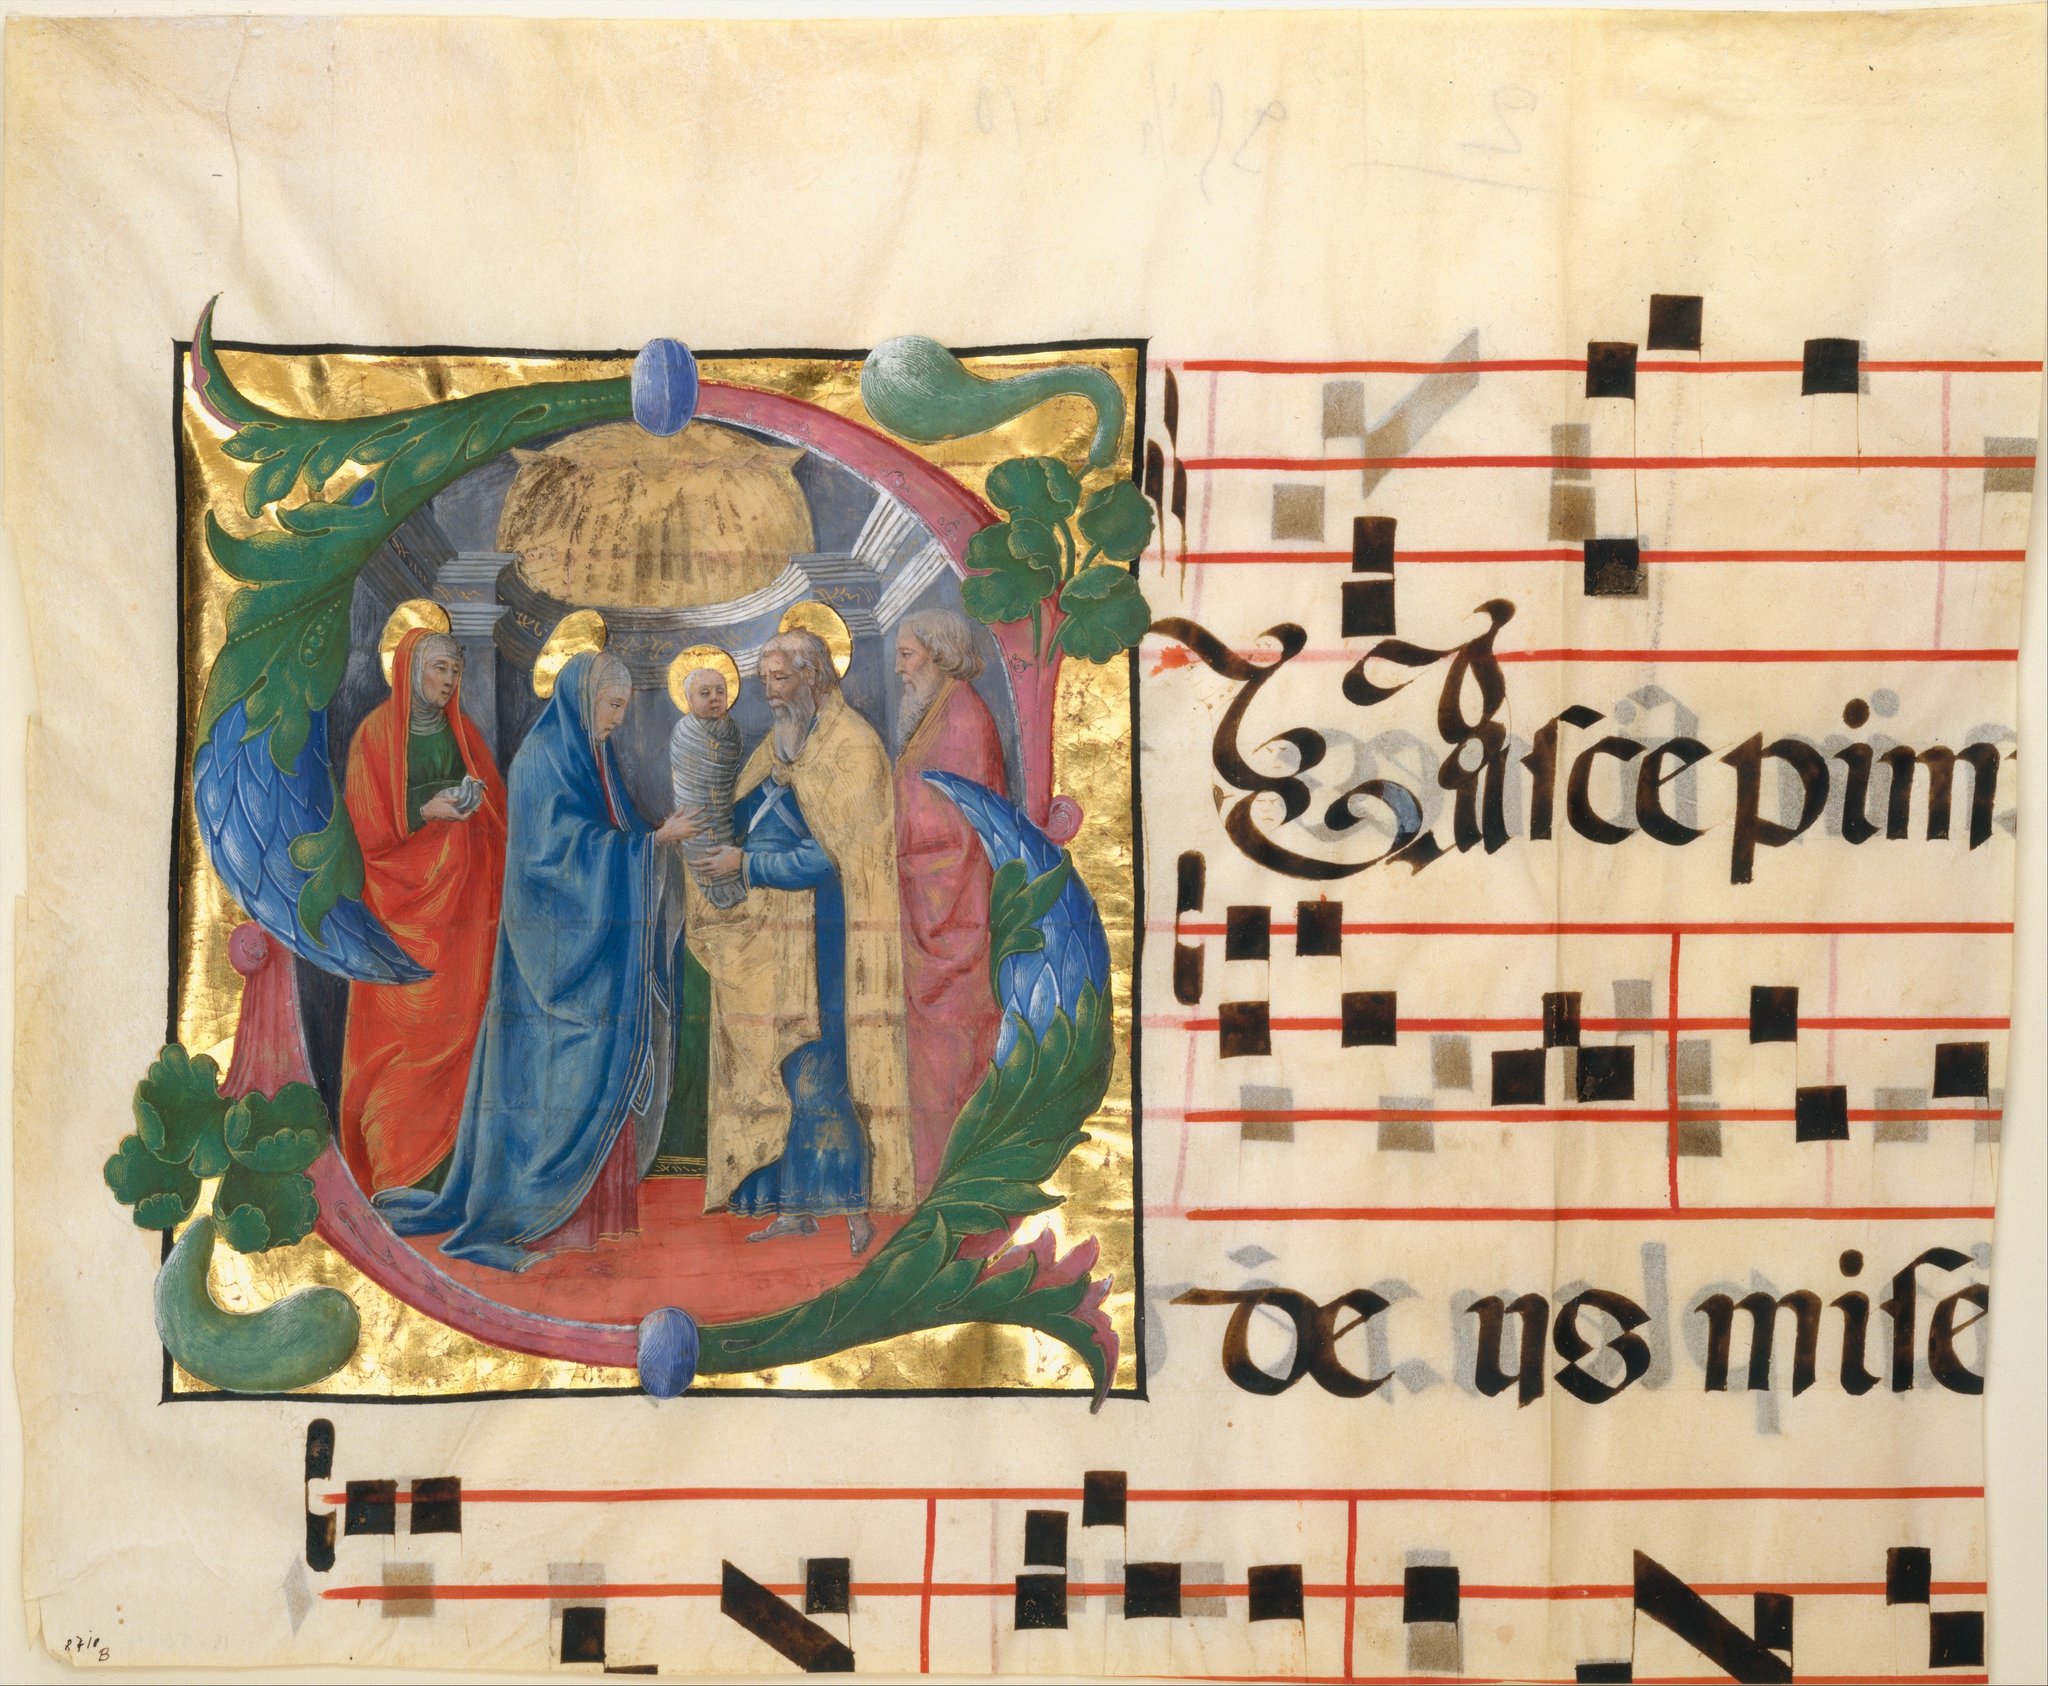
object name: gradual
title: Manuscript Illumination with the Presentation in the Temple in an Initial S, from a Gradual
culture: italian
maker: cosmè tura (cosimo di domenico di bonaventura)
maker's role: artist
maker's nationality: italian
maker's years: 1433-1495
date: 1450-1460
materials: gold, ink, parchment, paint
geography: italy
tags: infants,men,women